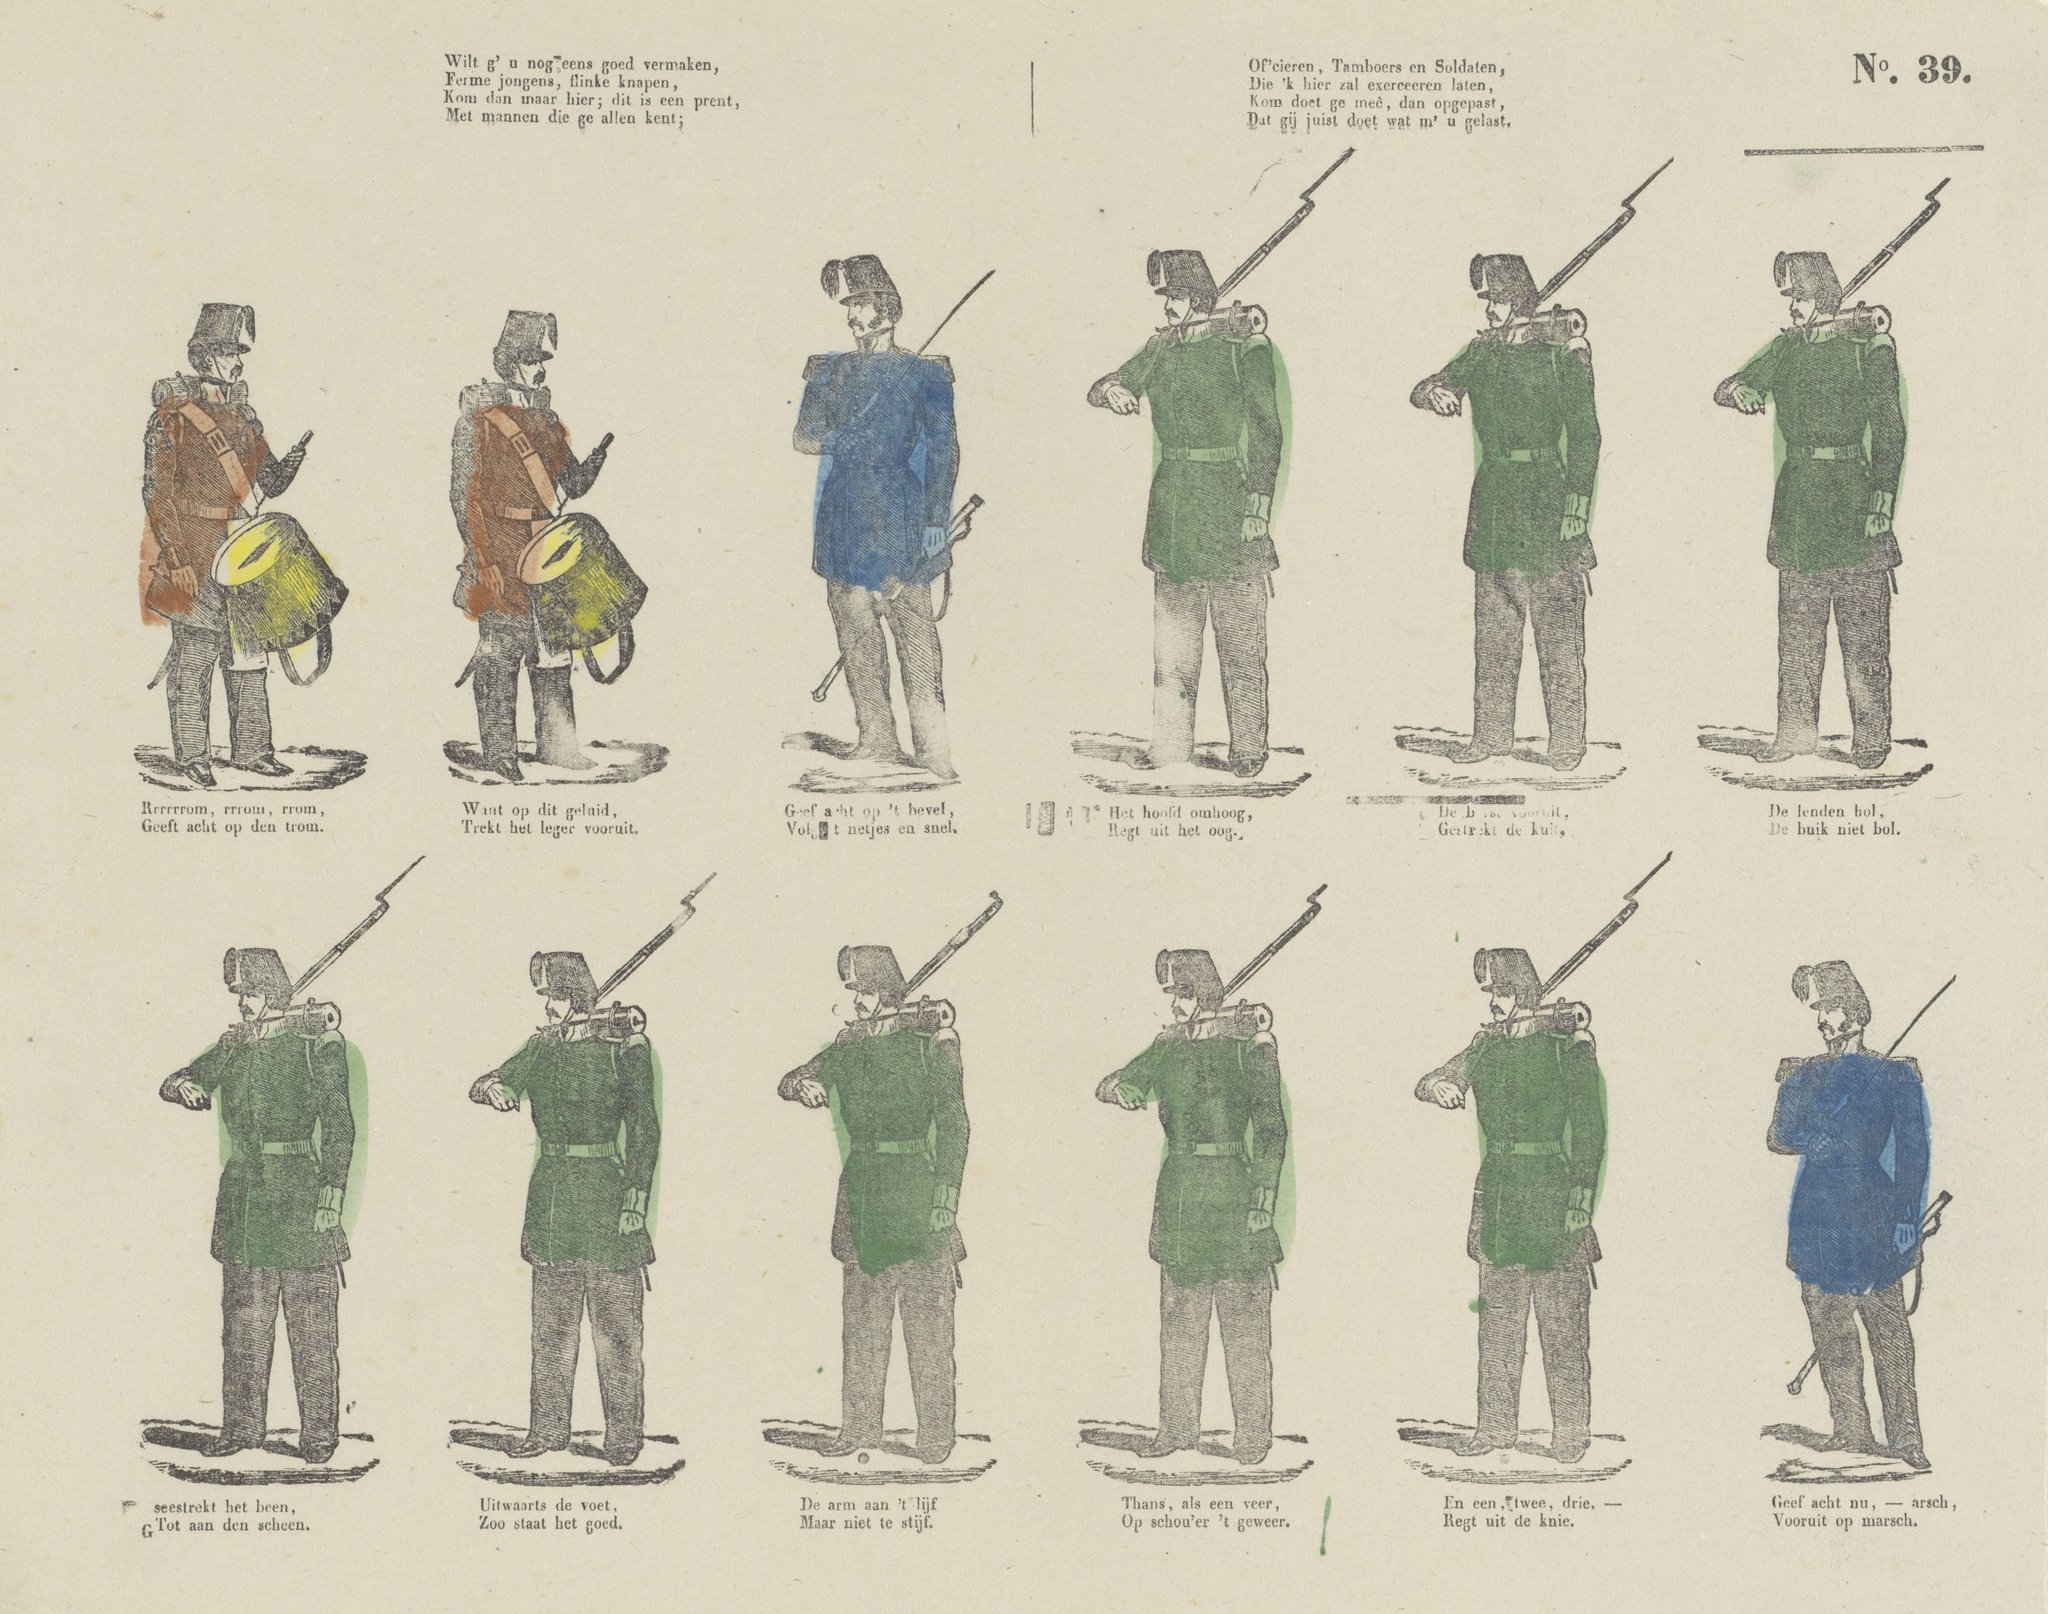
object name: print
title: Wilt g' u nog eens goed vermaken, / Ferme jongens, flinke knapen [(...)]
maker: Anonymous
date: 1850-1870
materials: paper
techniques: colour, letterpress printing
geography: netherlands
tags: the soldier; the soldier's life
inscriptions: collector's mark: Lugt 2760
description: Blad met 12 voorstellingen van militairen. Onder elke afbeelding een tweeregelig vers. Rechtsboven genummerd: No. 39.